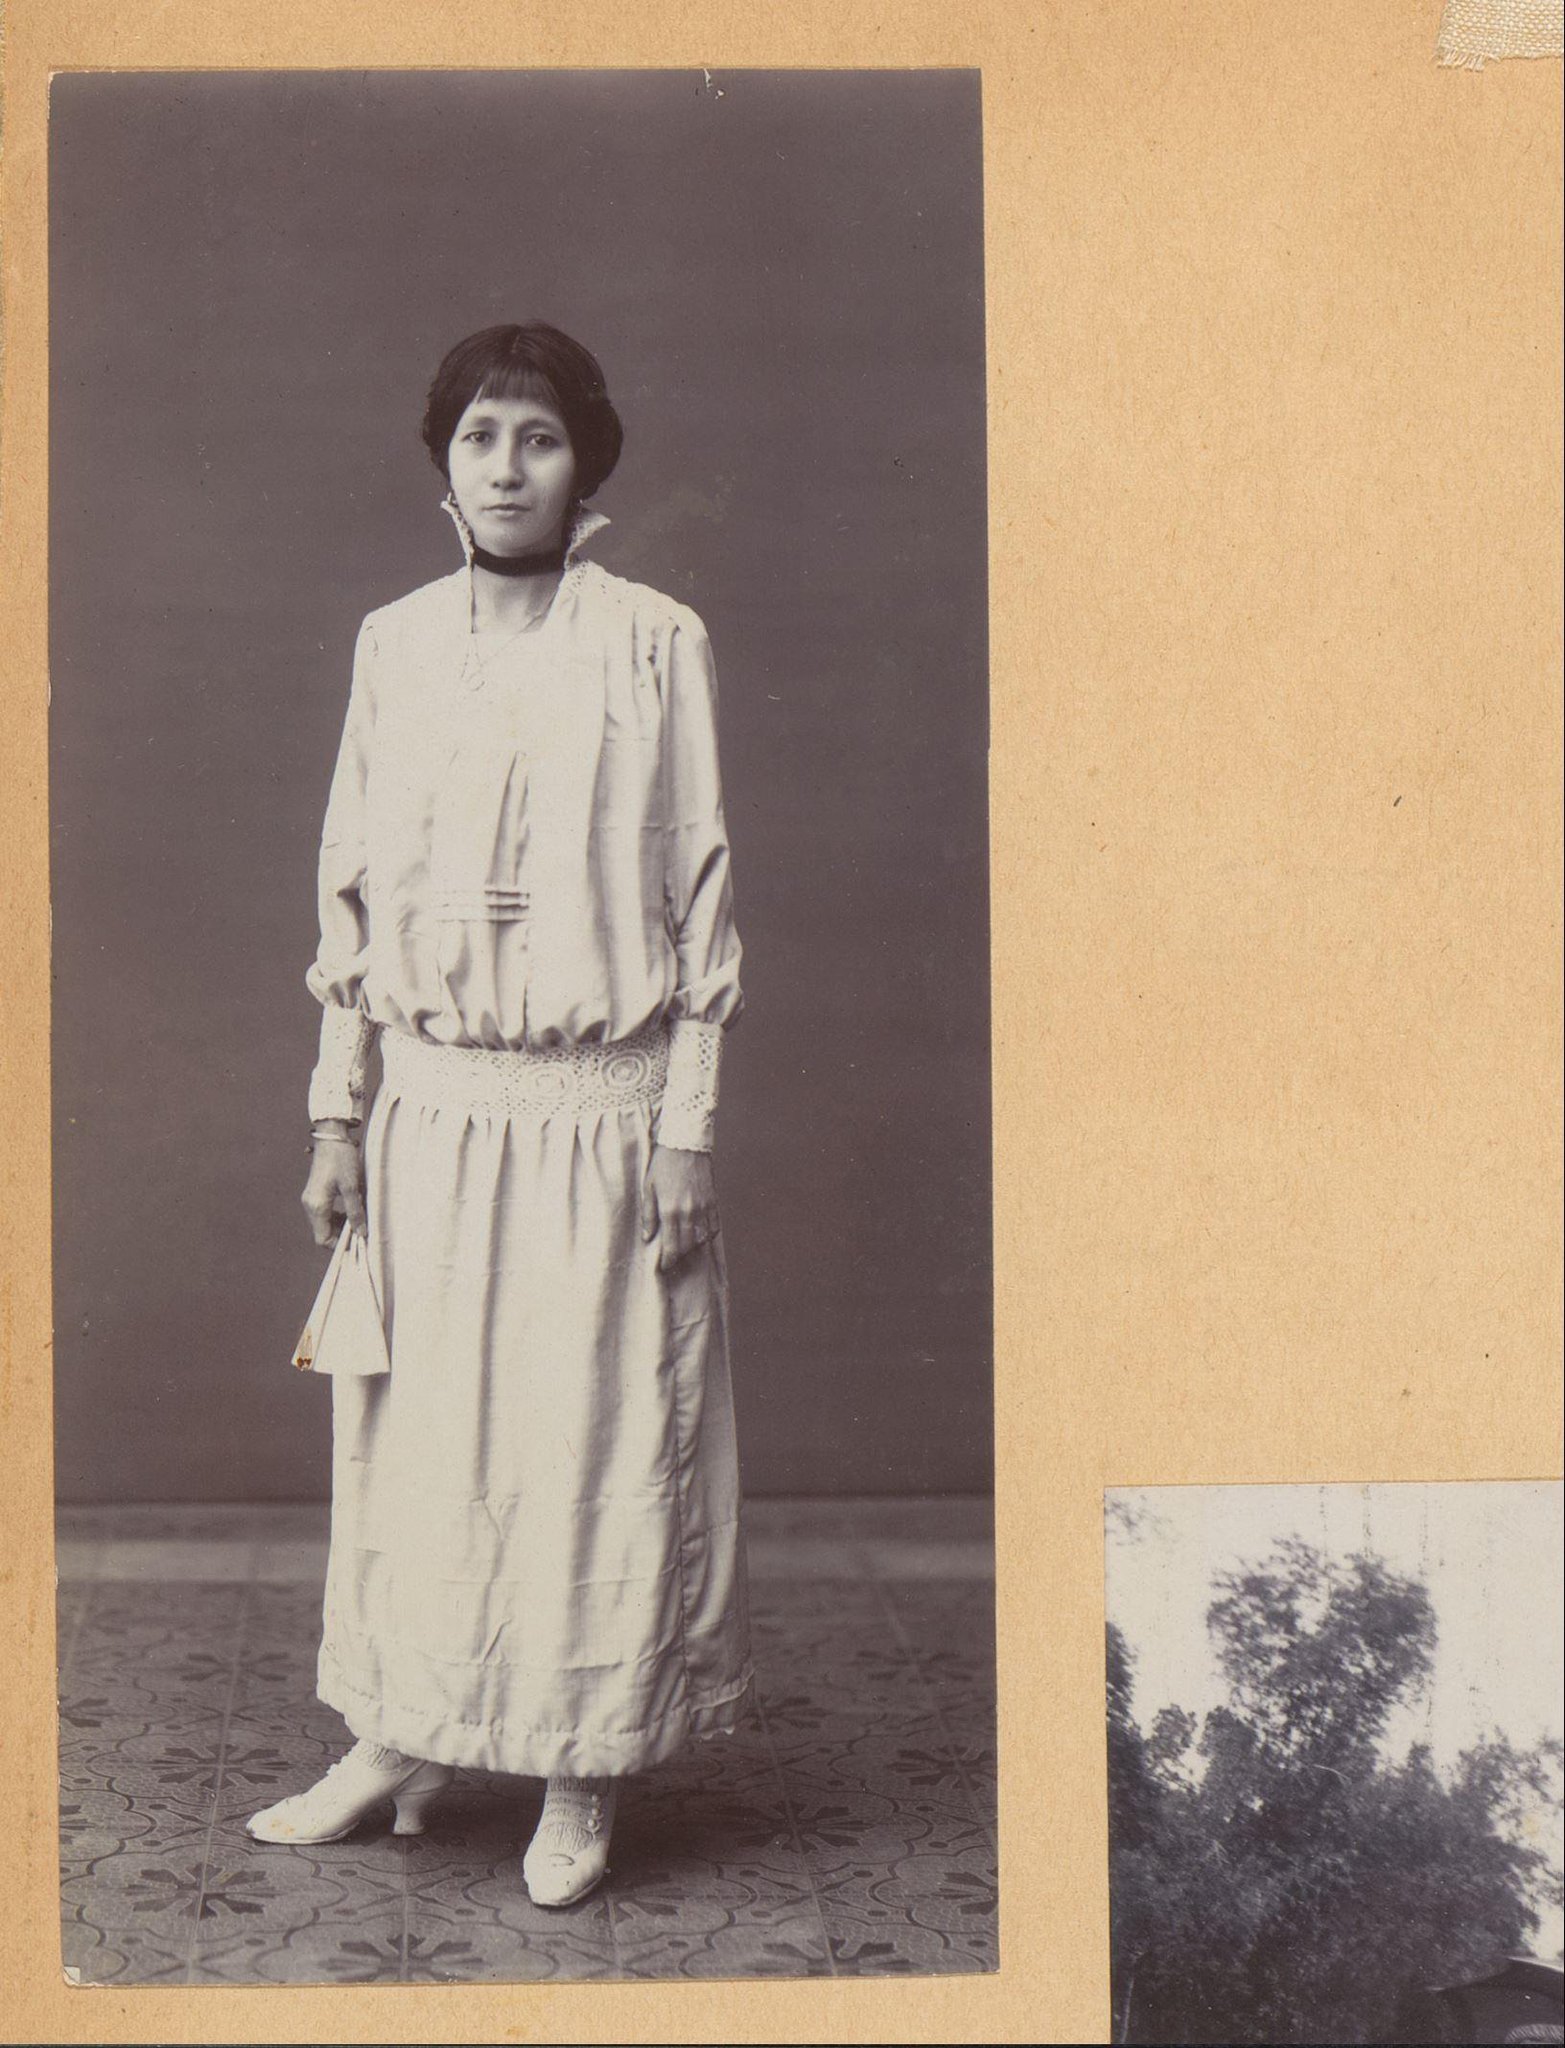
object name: photograph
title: Portret van een jonge vrouw in een blouse en een rok in Nederlands-Indië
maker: Anonymous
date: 1916-1917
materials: photographic support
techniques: gelatin silver print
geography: dutch east indies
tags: adult woman, clothing for the upper part of the body: blouse, skirt, dutch east indies, the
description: Onderdeel van Familiealbum met foto's van een familie in de voormalige kolonie Nederlands-Indië en van een suikerfabriek in Purworejo.